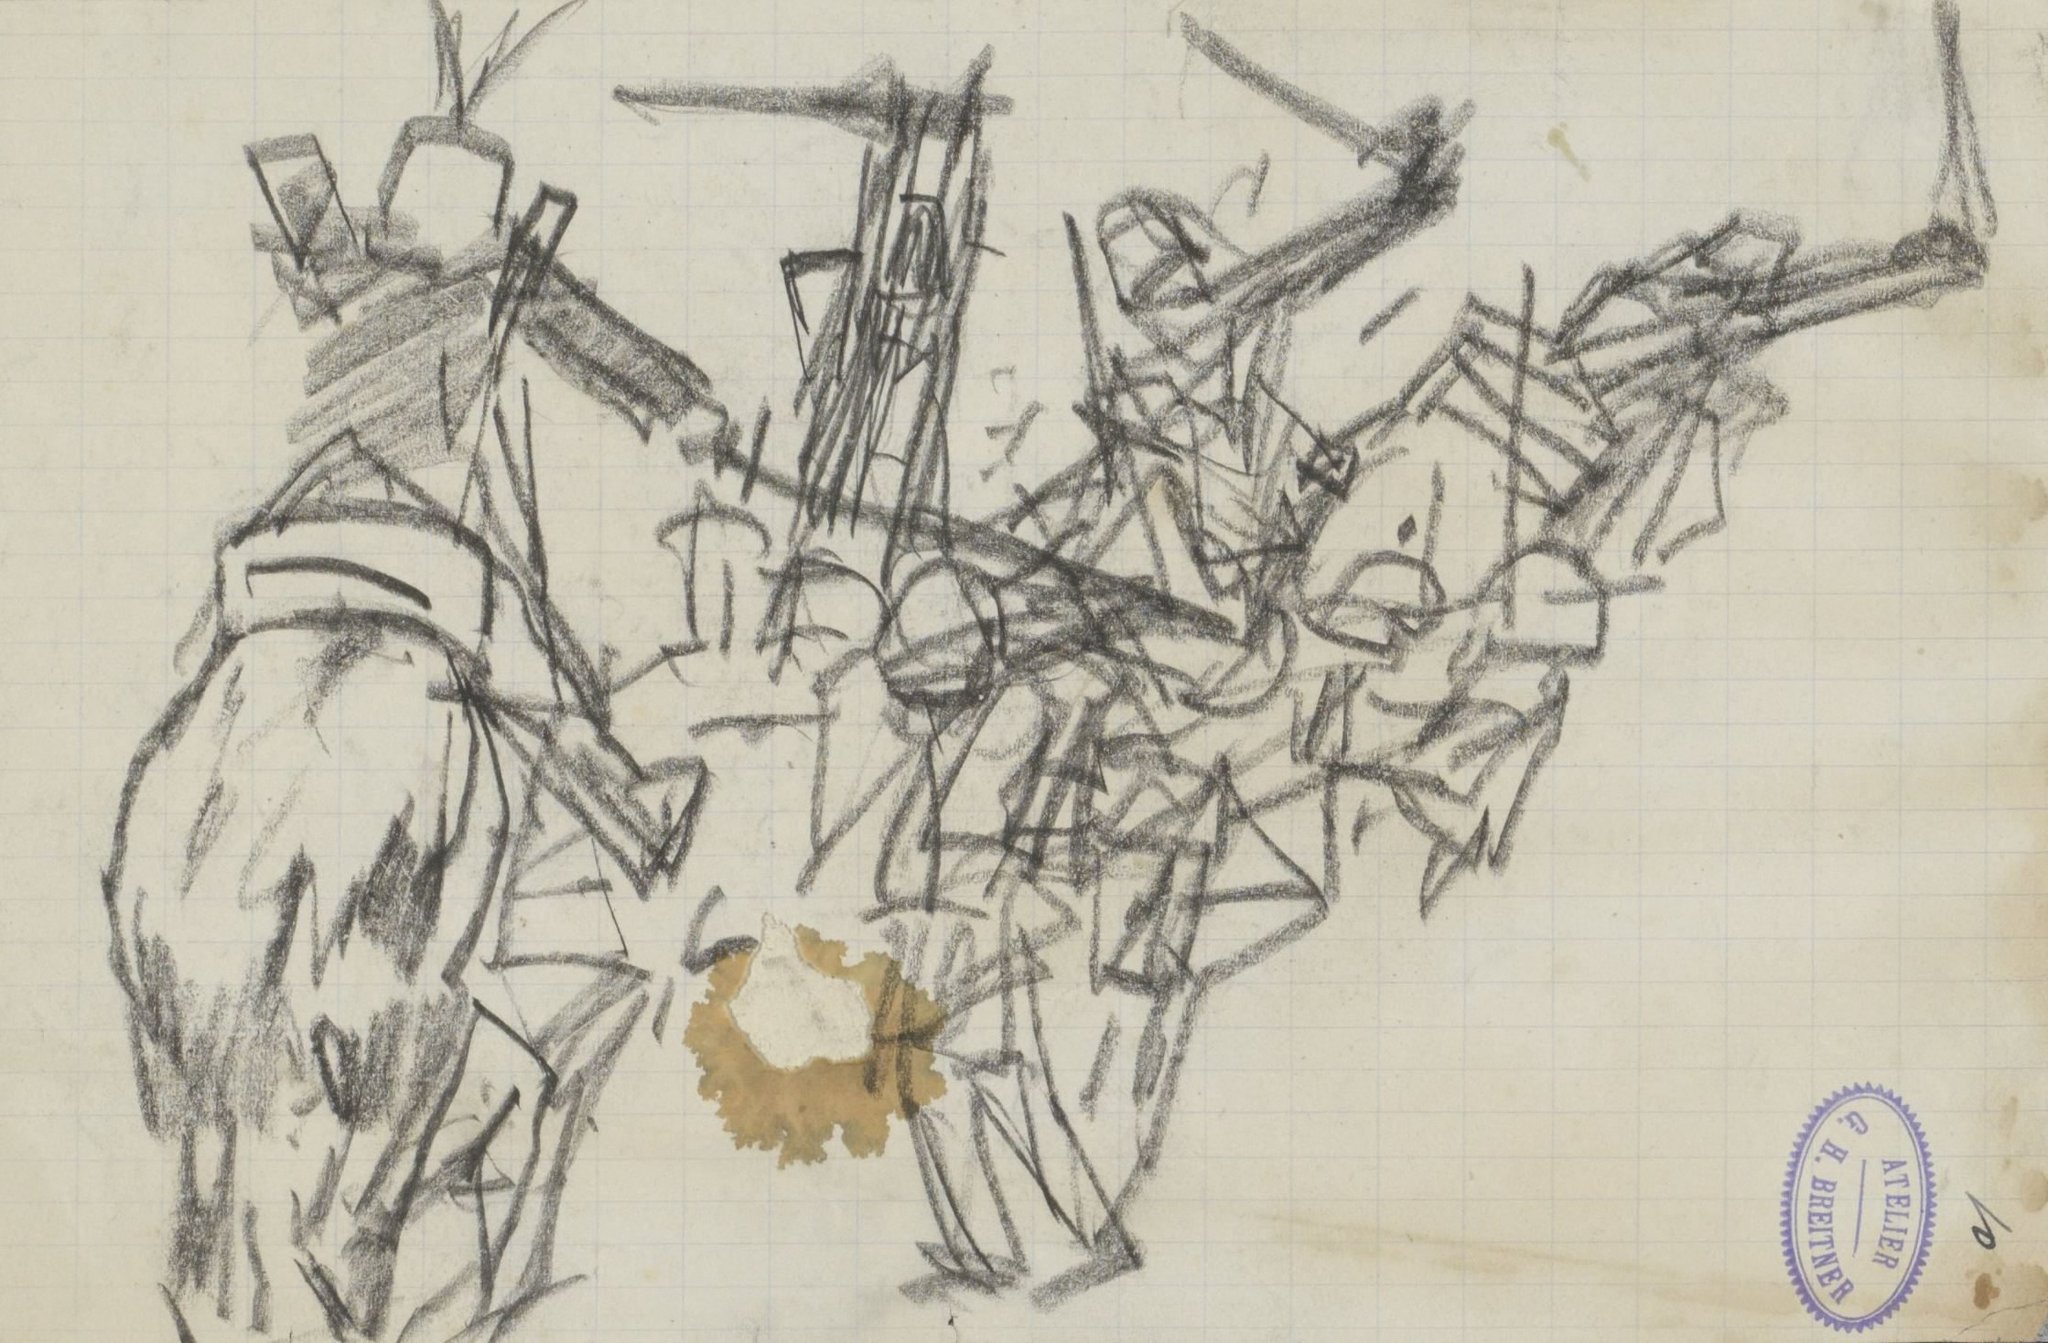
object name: drawing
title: Cavaleristen met opgeheven zwaarden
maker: george hendrik breitner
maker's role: draughtsman, painter, print maker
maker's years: 1857-1923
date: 1885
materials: chalk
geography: the hague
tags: (military) attack (+ cavalry, horsemen)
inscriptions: workshop stamp: Lugt 291d